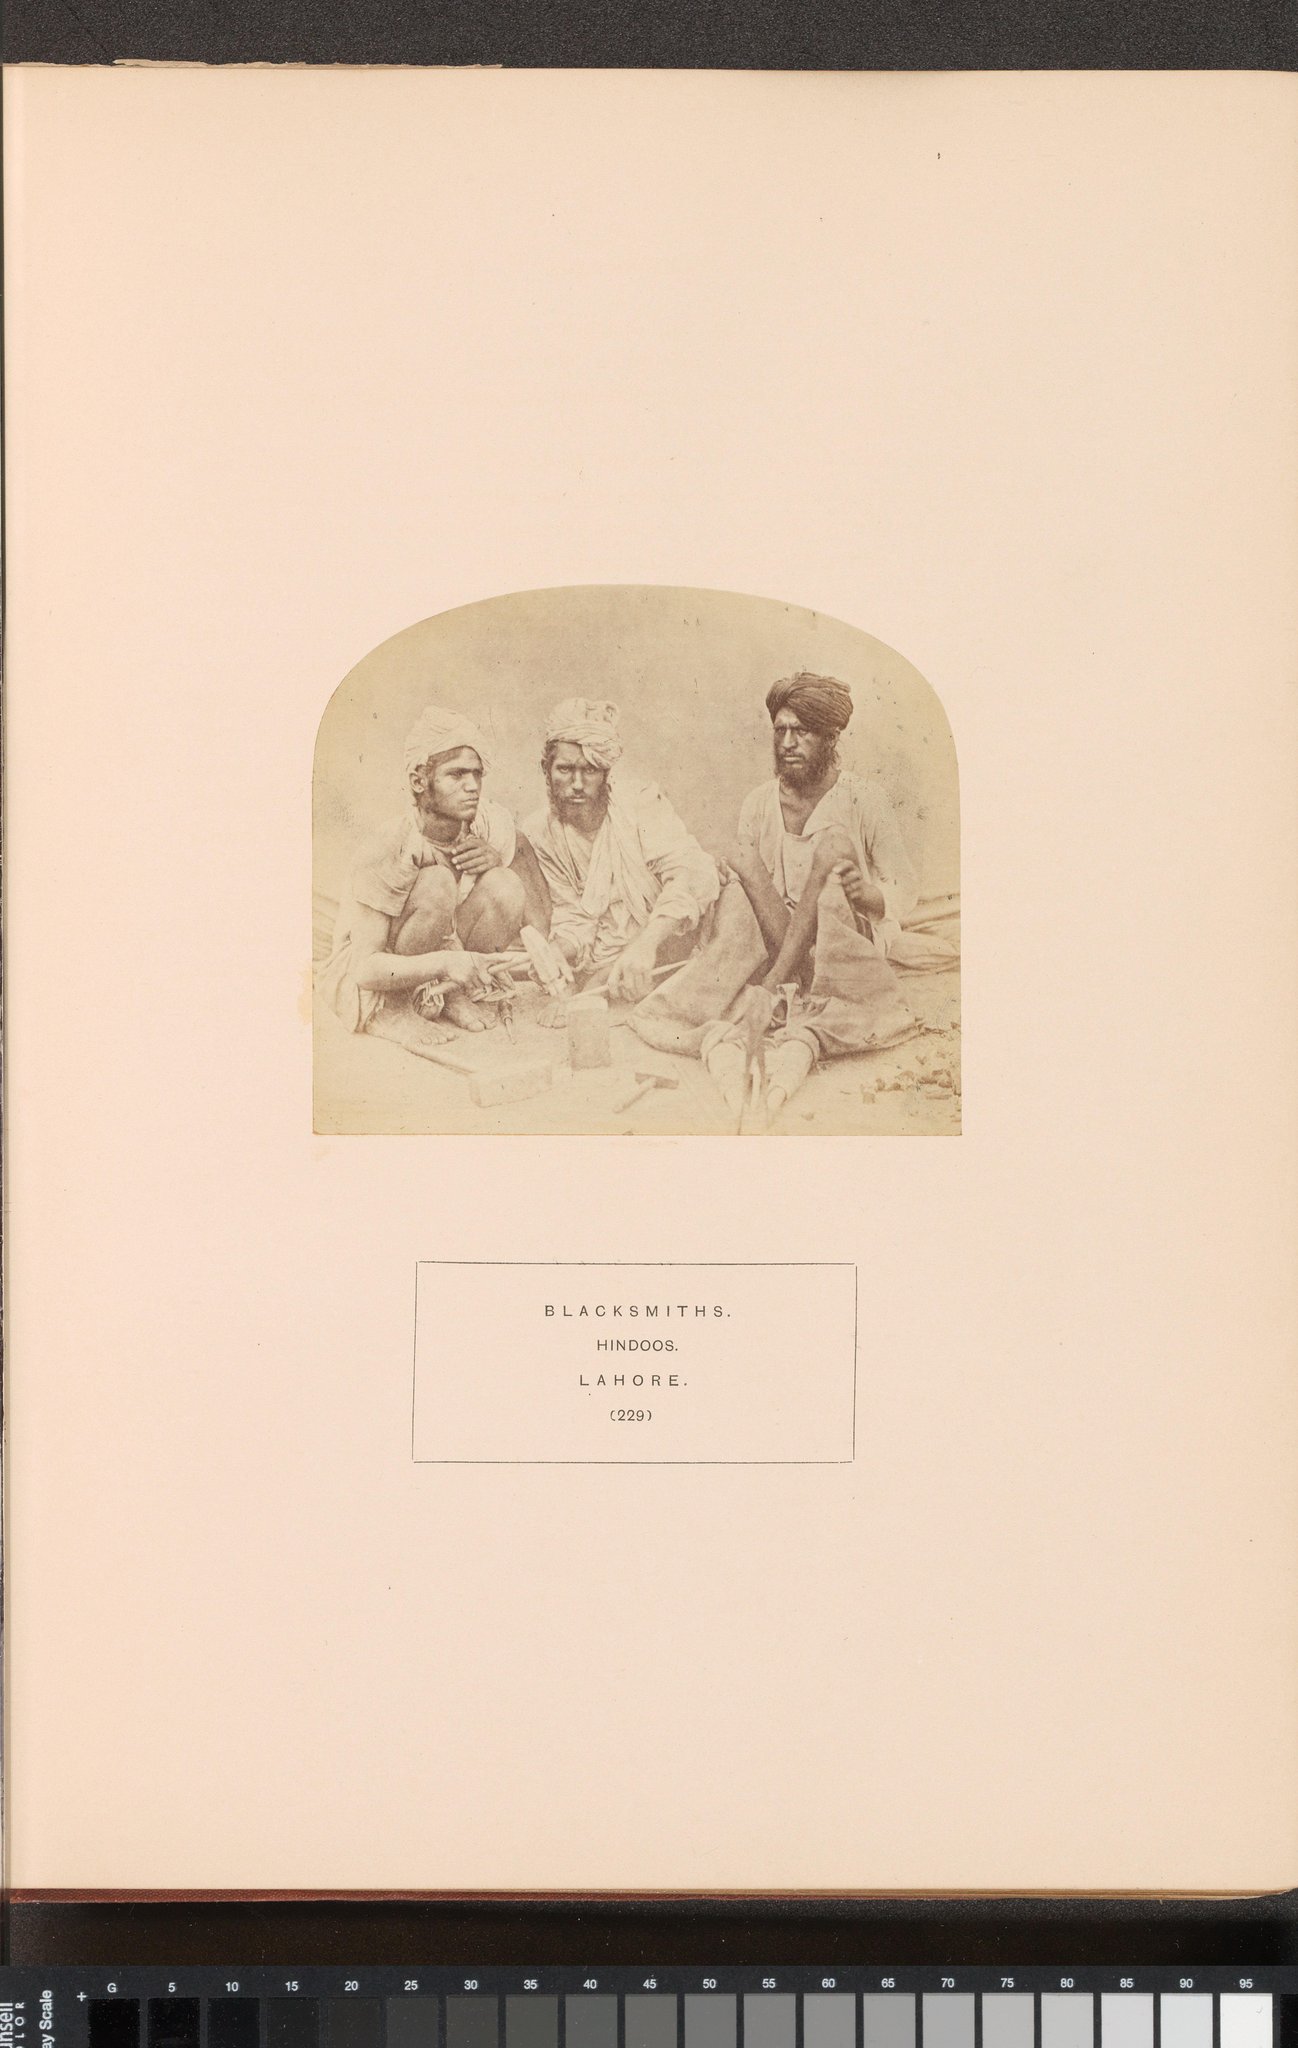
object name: photograph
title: Portrait of three unknown blacksmiths with tools from Lahore, Punjab, Pakistan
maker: Anonymous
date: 1862-1872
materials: photographic support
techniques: albumen print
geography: lahore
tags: smith, blacksmith, human races; peoples; nationalities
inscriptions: inscription: ‘BLACKSMITHS./ HINDOOS./ LAHORE.’, number: ‘(229)’